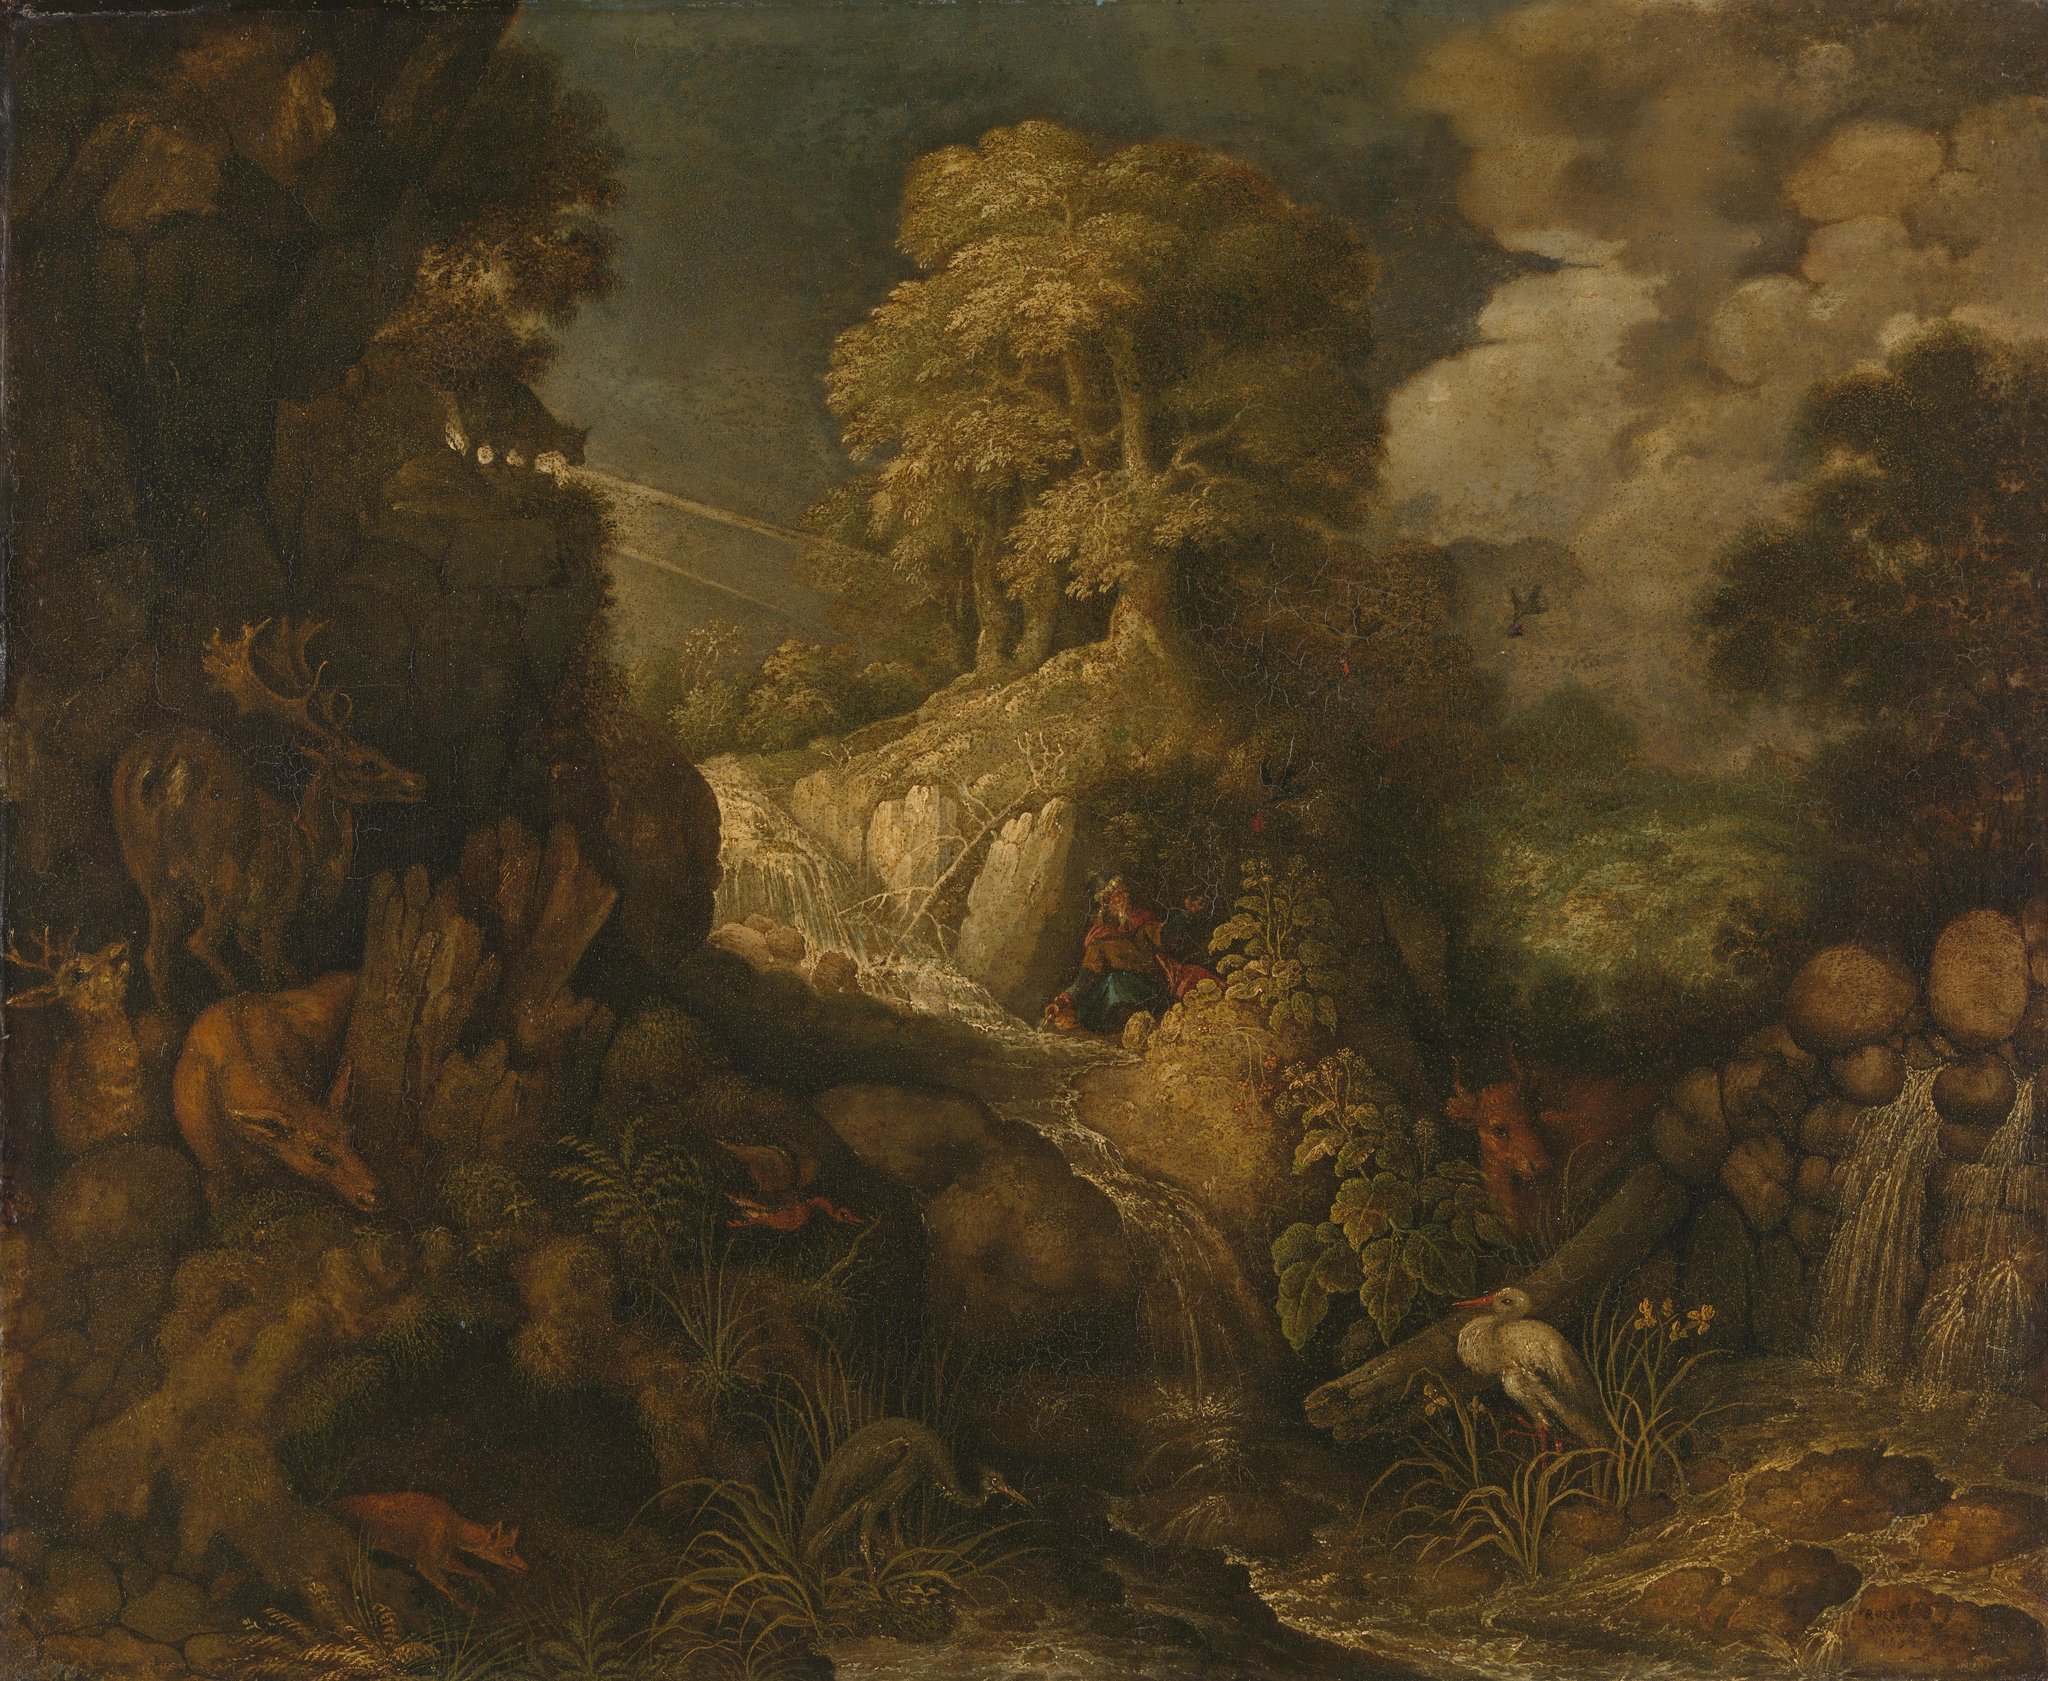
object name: painting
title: Elijah fed by the ravens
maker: roelant savery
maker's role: draughtsman, painter, print maker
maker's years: 1576-1639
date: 1634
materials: copper, oil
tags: elijah fed by the raven(s): while the prophet is living by the brook, ravens bring him food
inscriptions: signature and date, bottom right: ‘Roeland / Savery FE 16[3?]4’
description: Roelant Saverij (1578 - 1639). Elijah fed by the ravens, 1634. This woodland scene inhabited by animals depicts a story from the Old Testament. Elijah withdrew from the world and lived the life of a hermit, surviving on bread brought to him by ravens. At centre right we see Elijah; the ravens are more difficult to distinguish. Roelant Saverij came from Flanders, the cradle of landscape art. He was a court painter in Prague and from 1618 on was active in Utrecht. Painted on copper. Purchased in 1885.